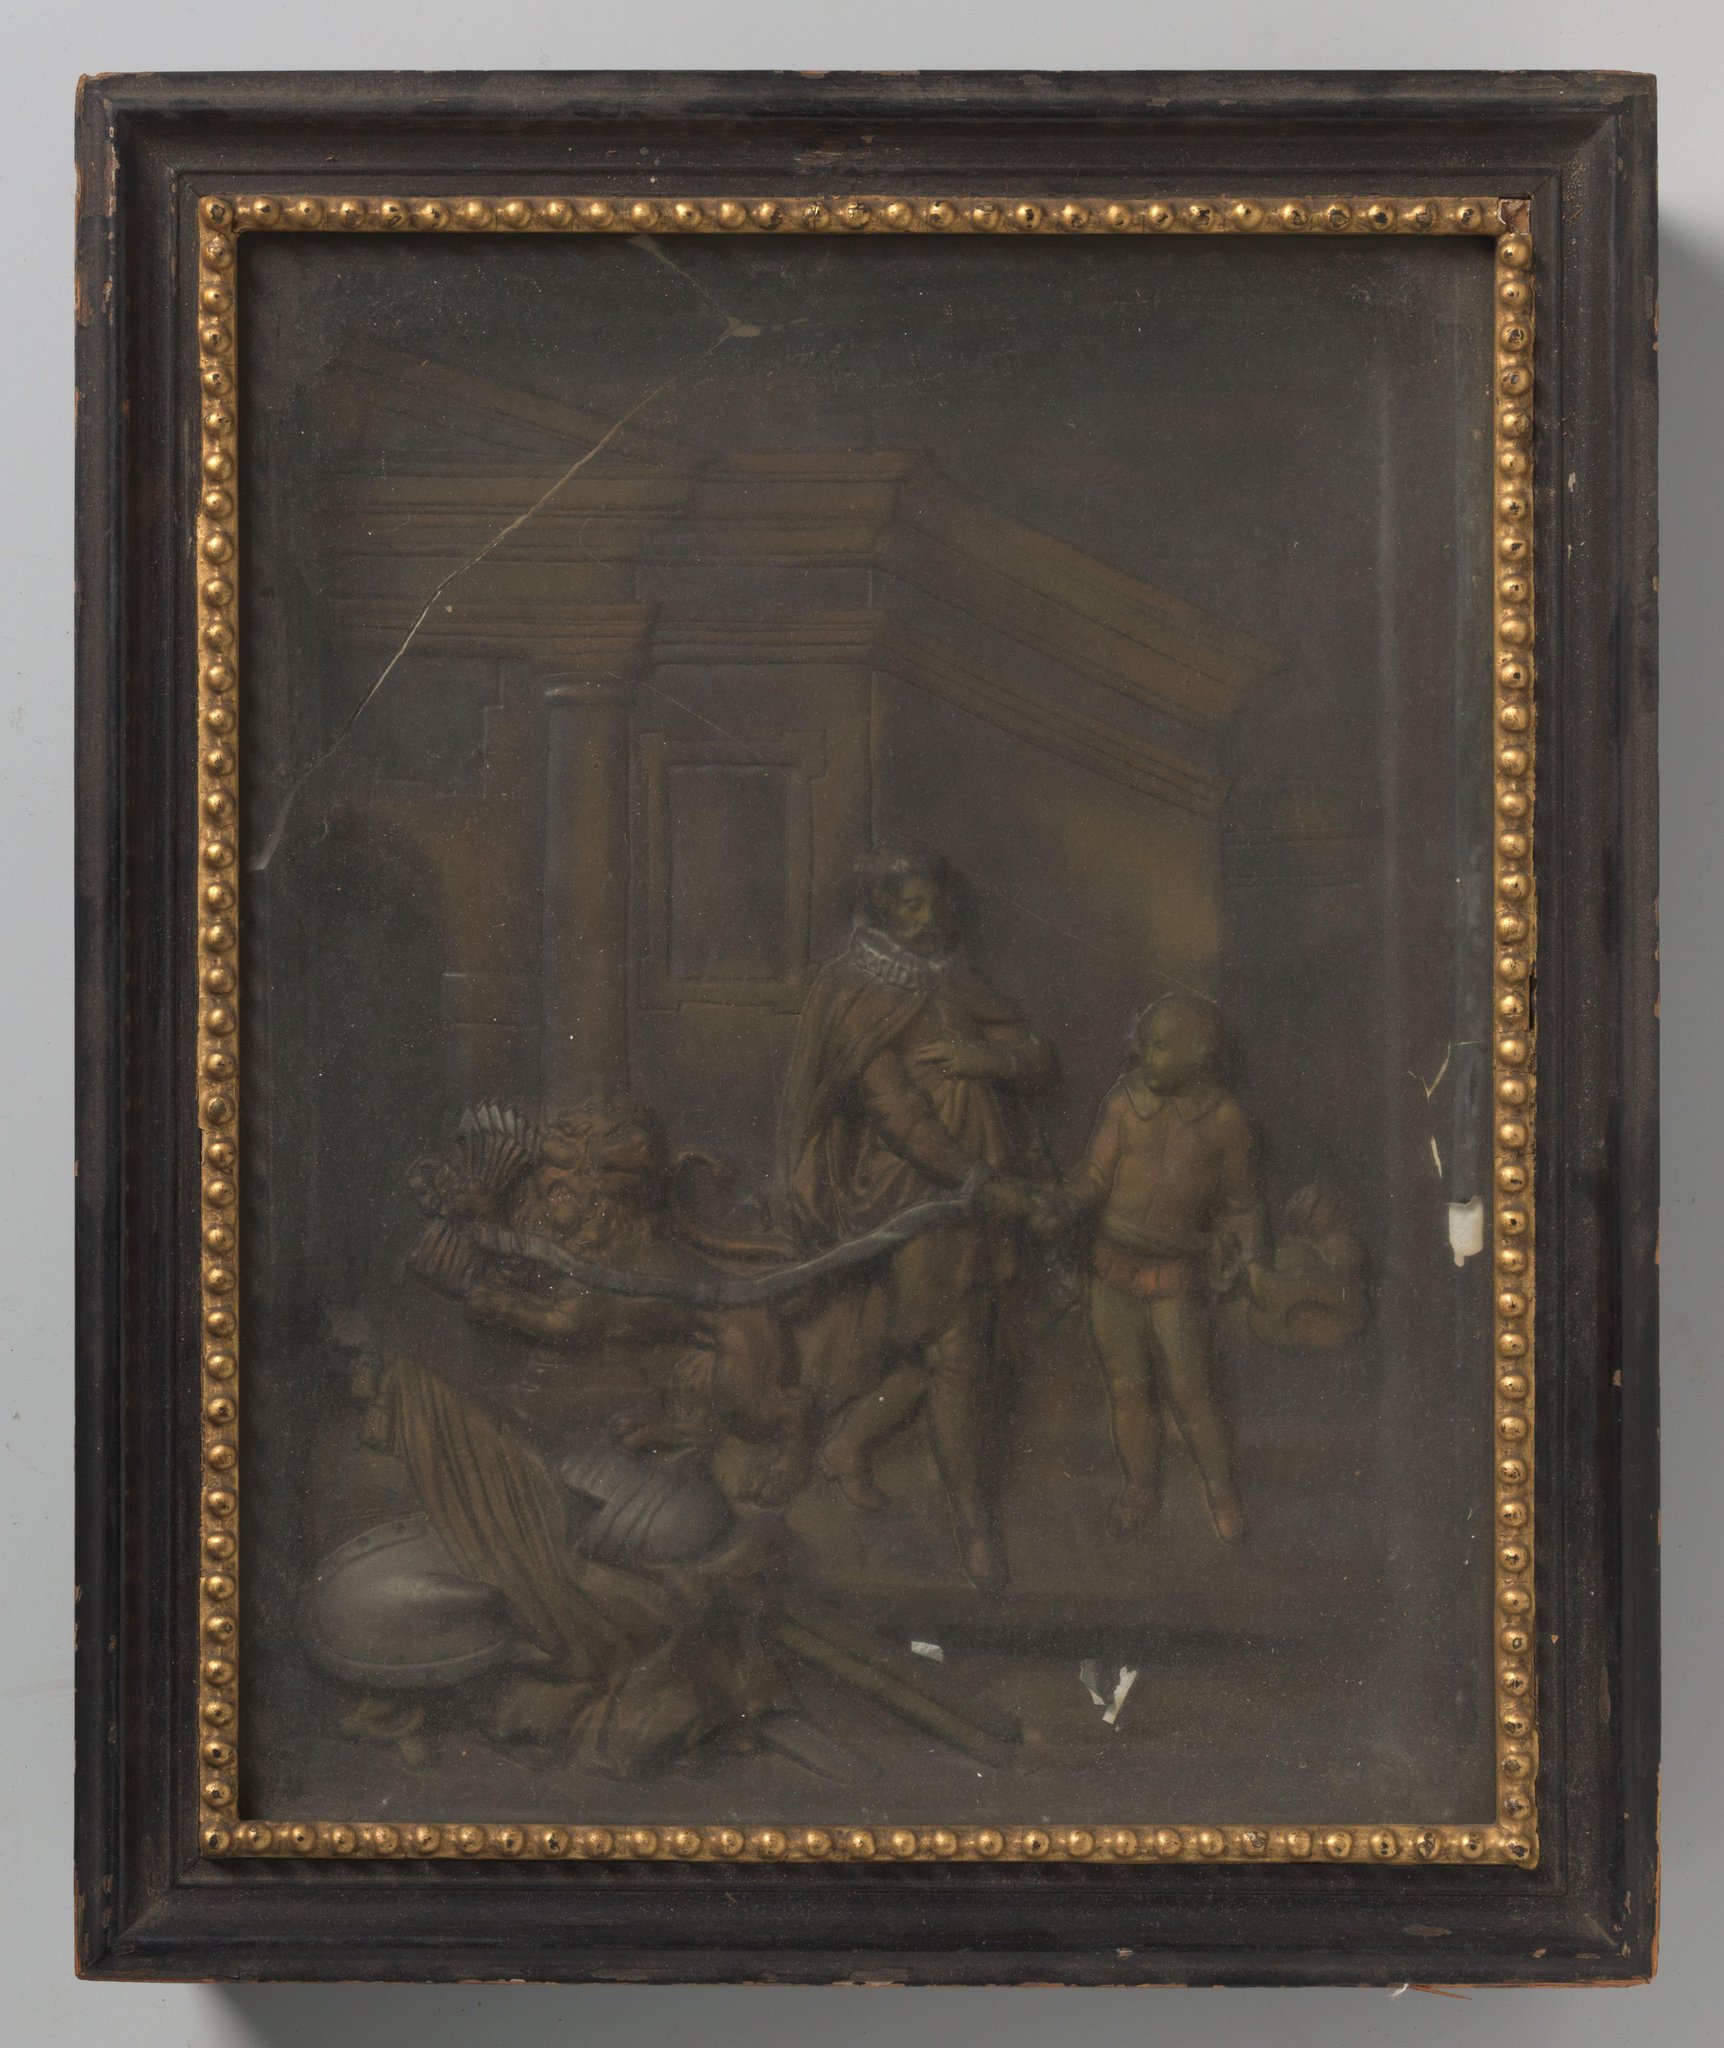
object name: relief sculpture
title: Reliëf van gekleurd gips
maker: Anonymous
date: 1700-1799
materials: gypsum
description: Een van zes gekleurde gipsreliëfs achtger glas in lijst, voorstellende de vrijheid enz. met Prins Willem I tot Prins Willem V.